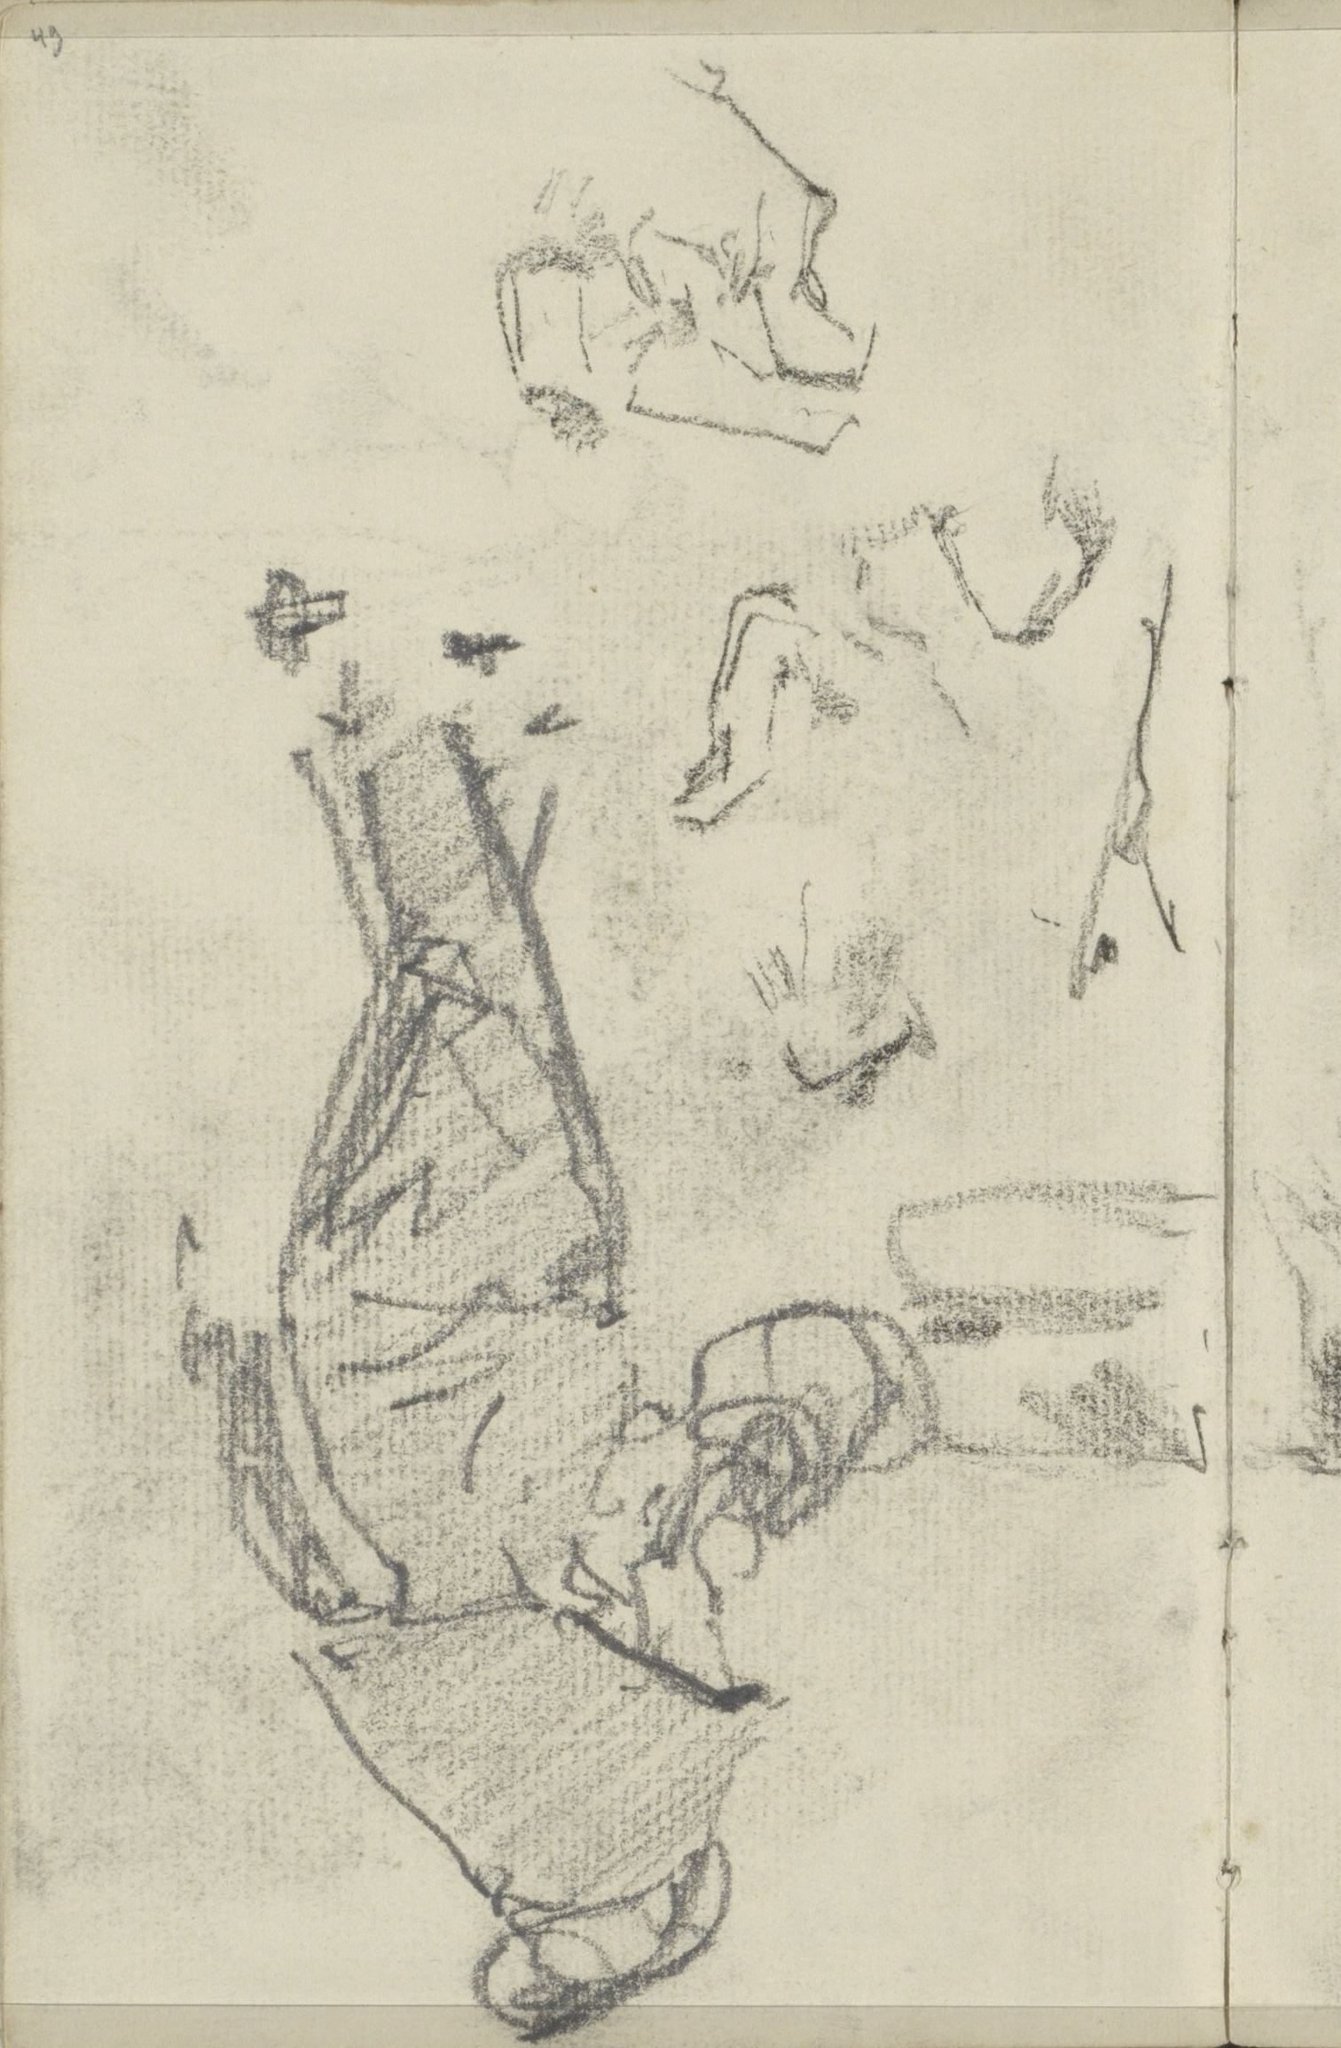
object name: sketchbook leaf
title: Wandelende vrouw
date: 1882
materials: chalk, paper, pencil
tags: walking - aa - female human figure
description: Pagina 49 uit een schetsboek met 31 bladen vervaardigd te Den Haag en Rotterdam.